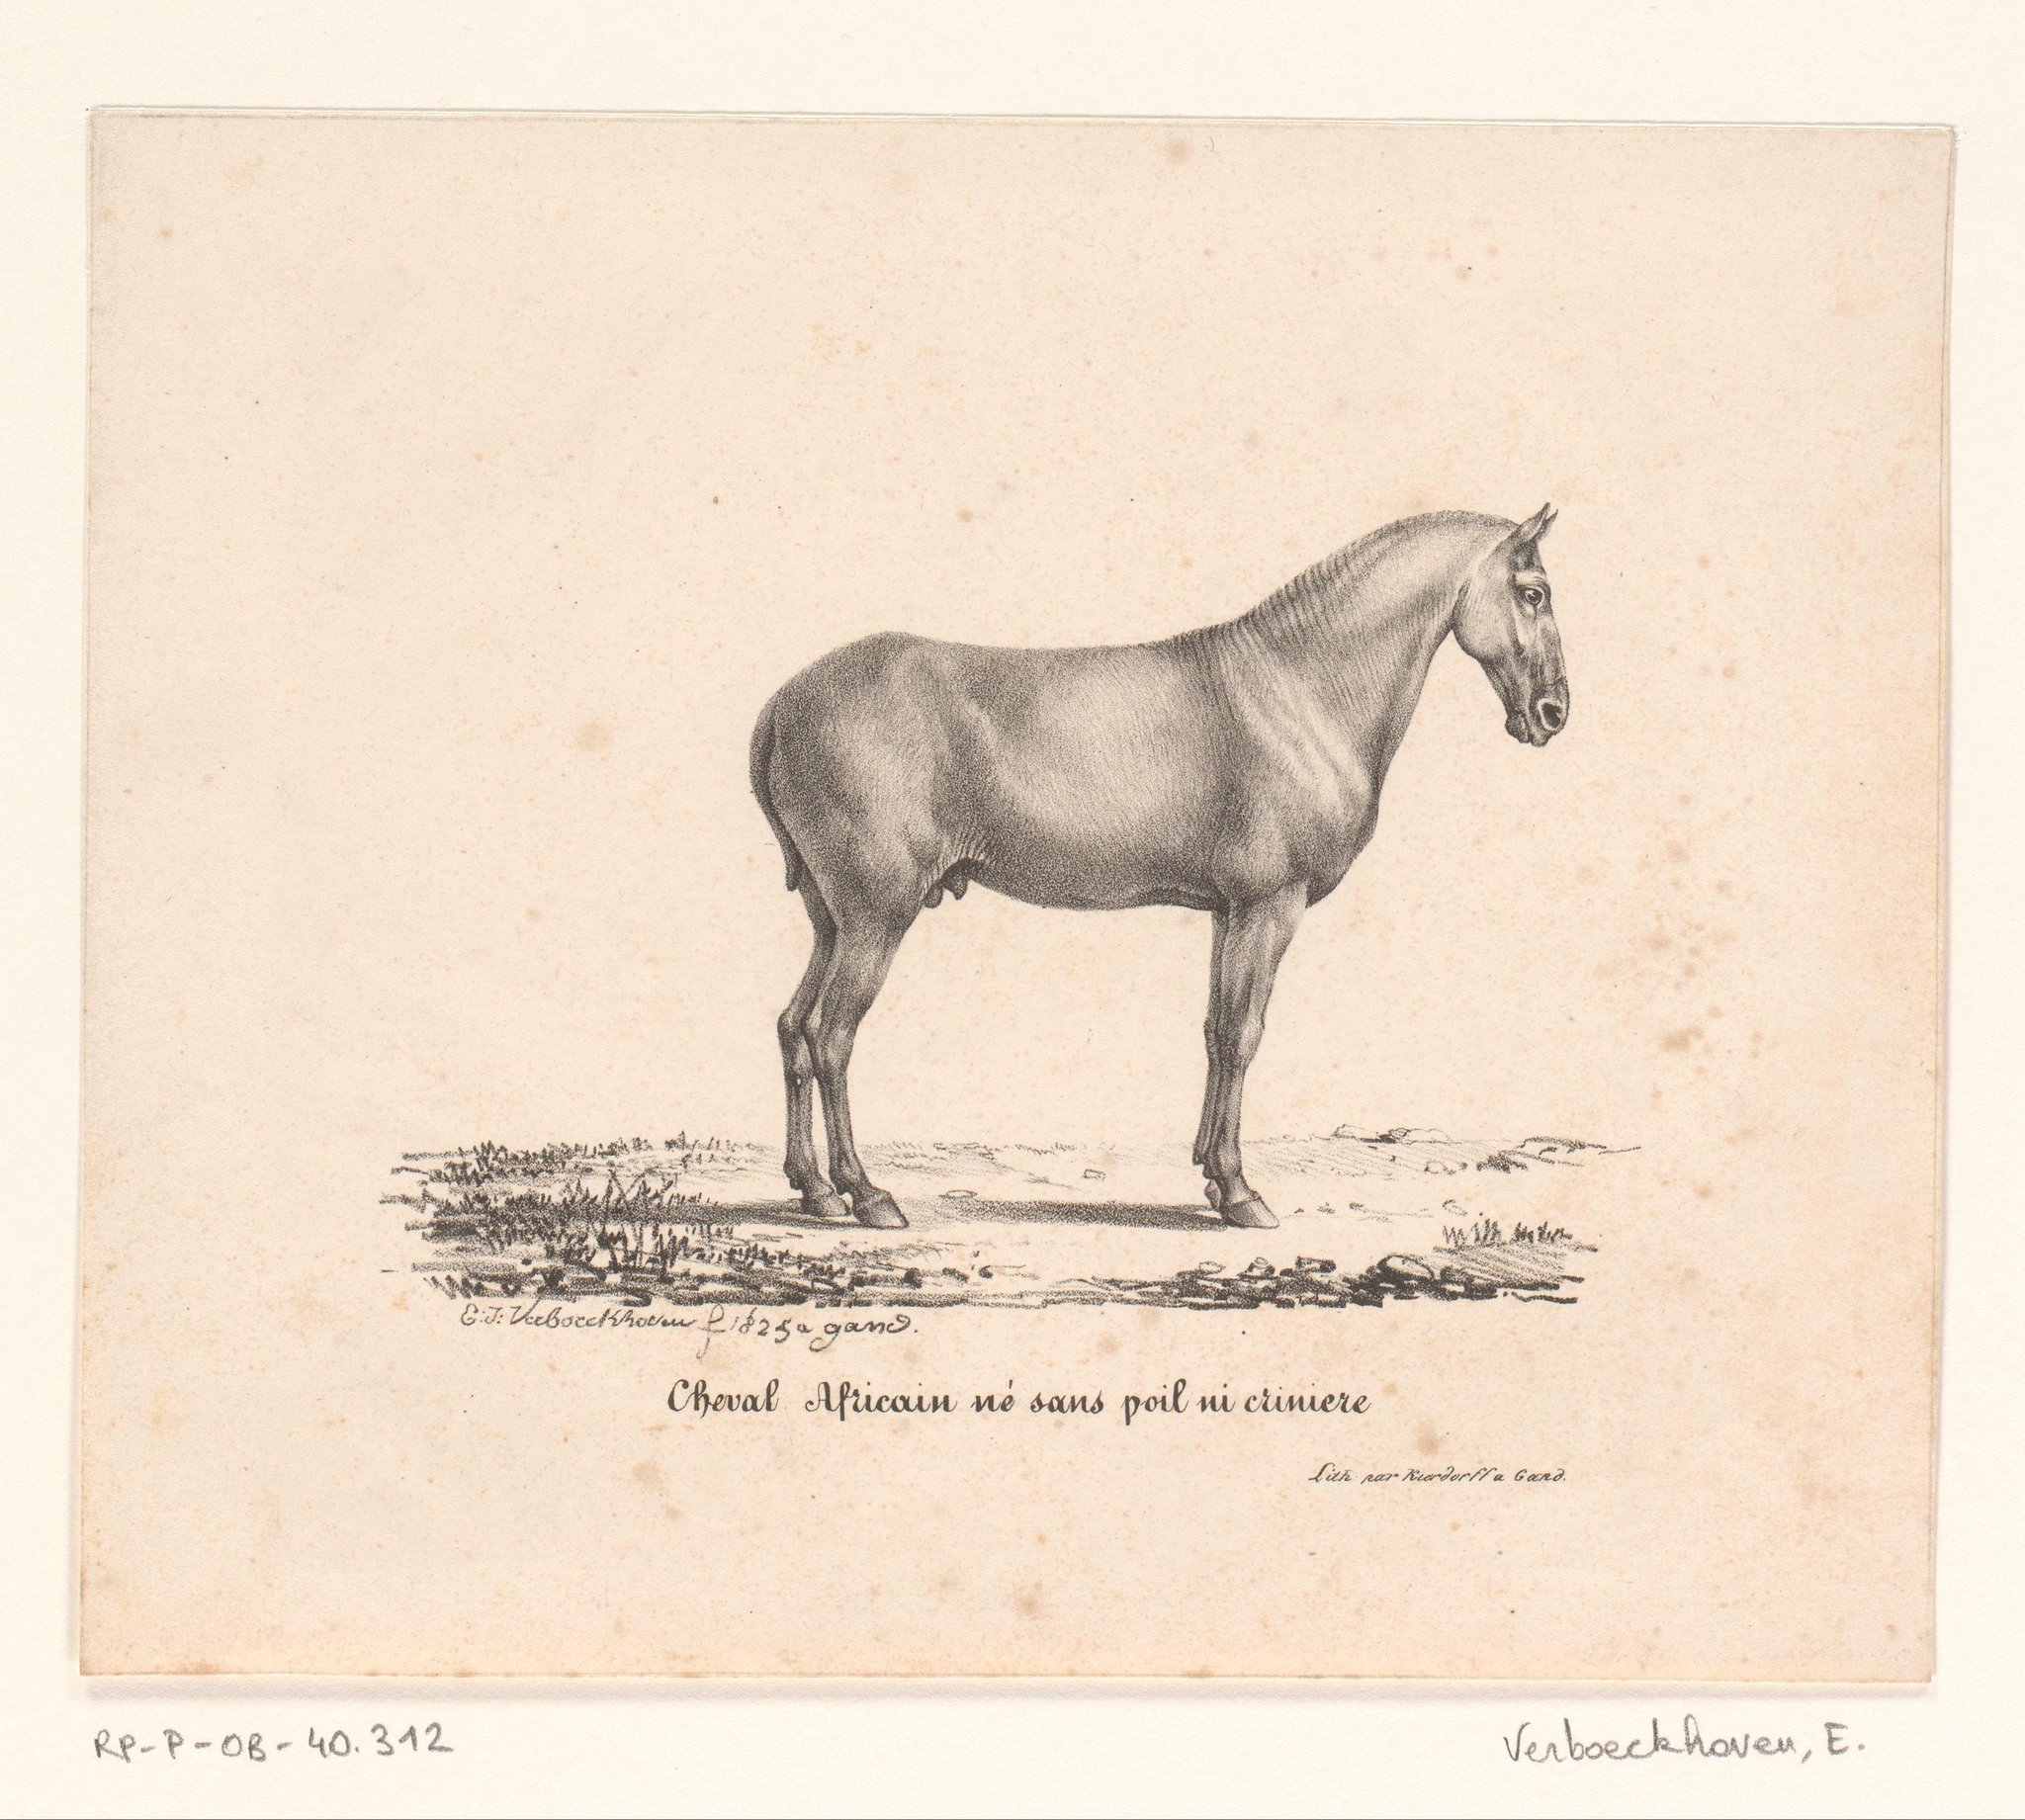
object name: print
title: Afrikaans paard zonder staart en manen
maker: franciscus mattheus jozef kierdorff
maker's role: printer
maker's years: 1777-1855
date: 1825-1828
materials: paper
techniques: lithograph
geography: ghent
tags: horse